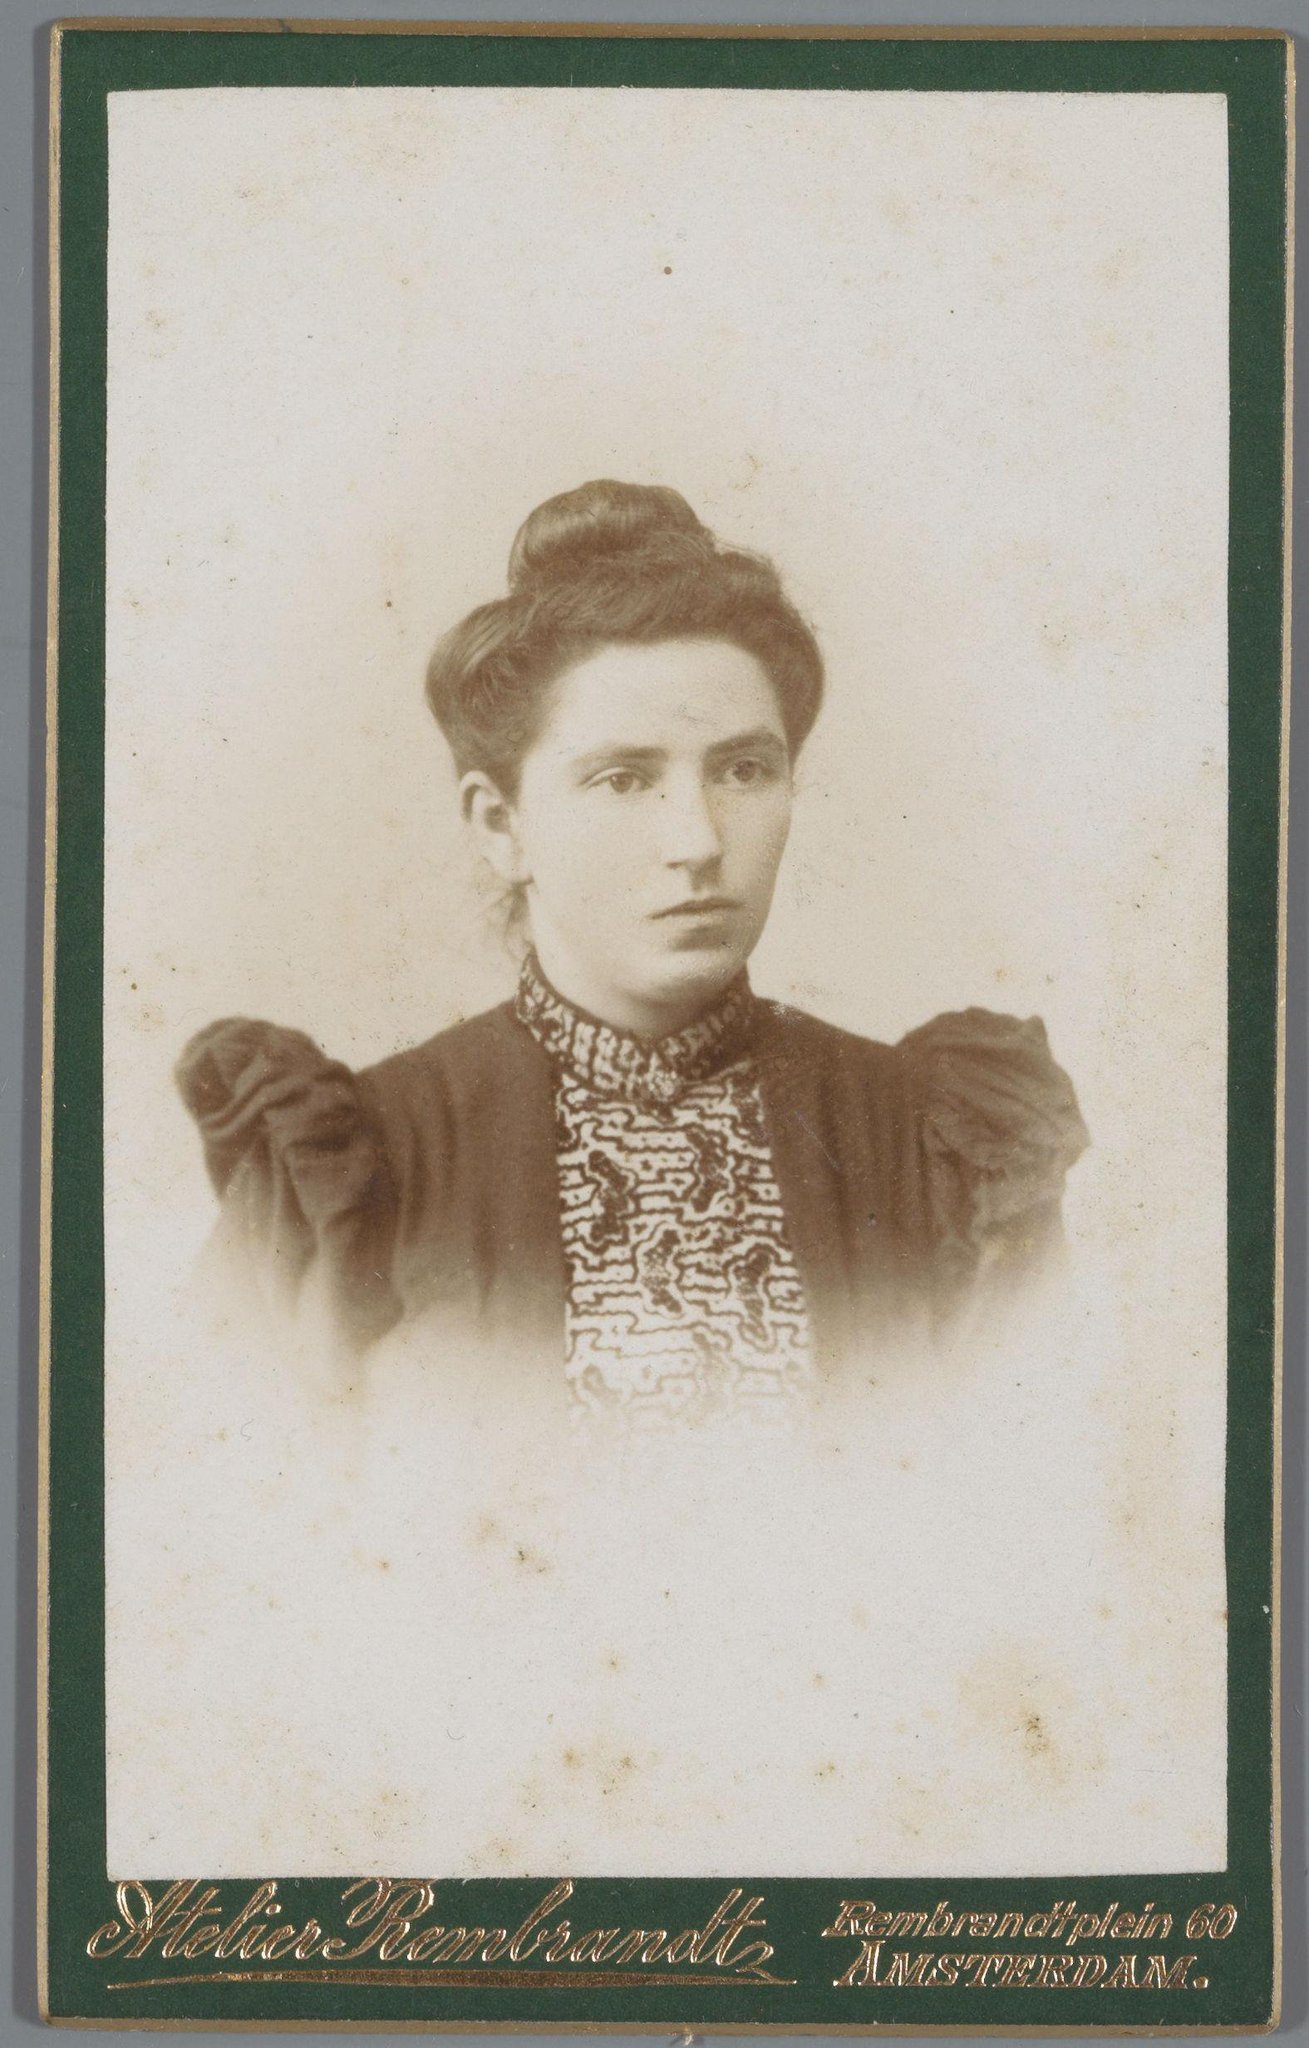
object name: photograph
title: Portret van een onbekende vrouw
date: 1880-1911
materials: cardboard, photographic support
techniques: collodion silver print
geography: amsterdam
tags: historical persons - bb - woman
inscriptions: inscription: ‘No................/ PHOTOGRAPHIE/ ARTISTIQUE/ Rembrandt/ AMSTERDAM/ Rembrandtplein 60./ Specialiteit in vergrootingen/ tot levensgroot./ DE PLAAT BLIJFT TER NABESTELLING/ BEWAARD.’